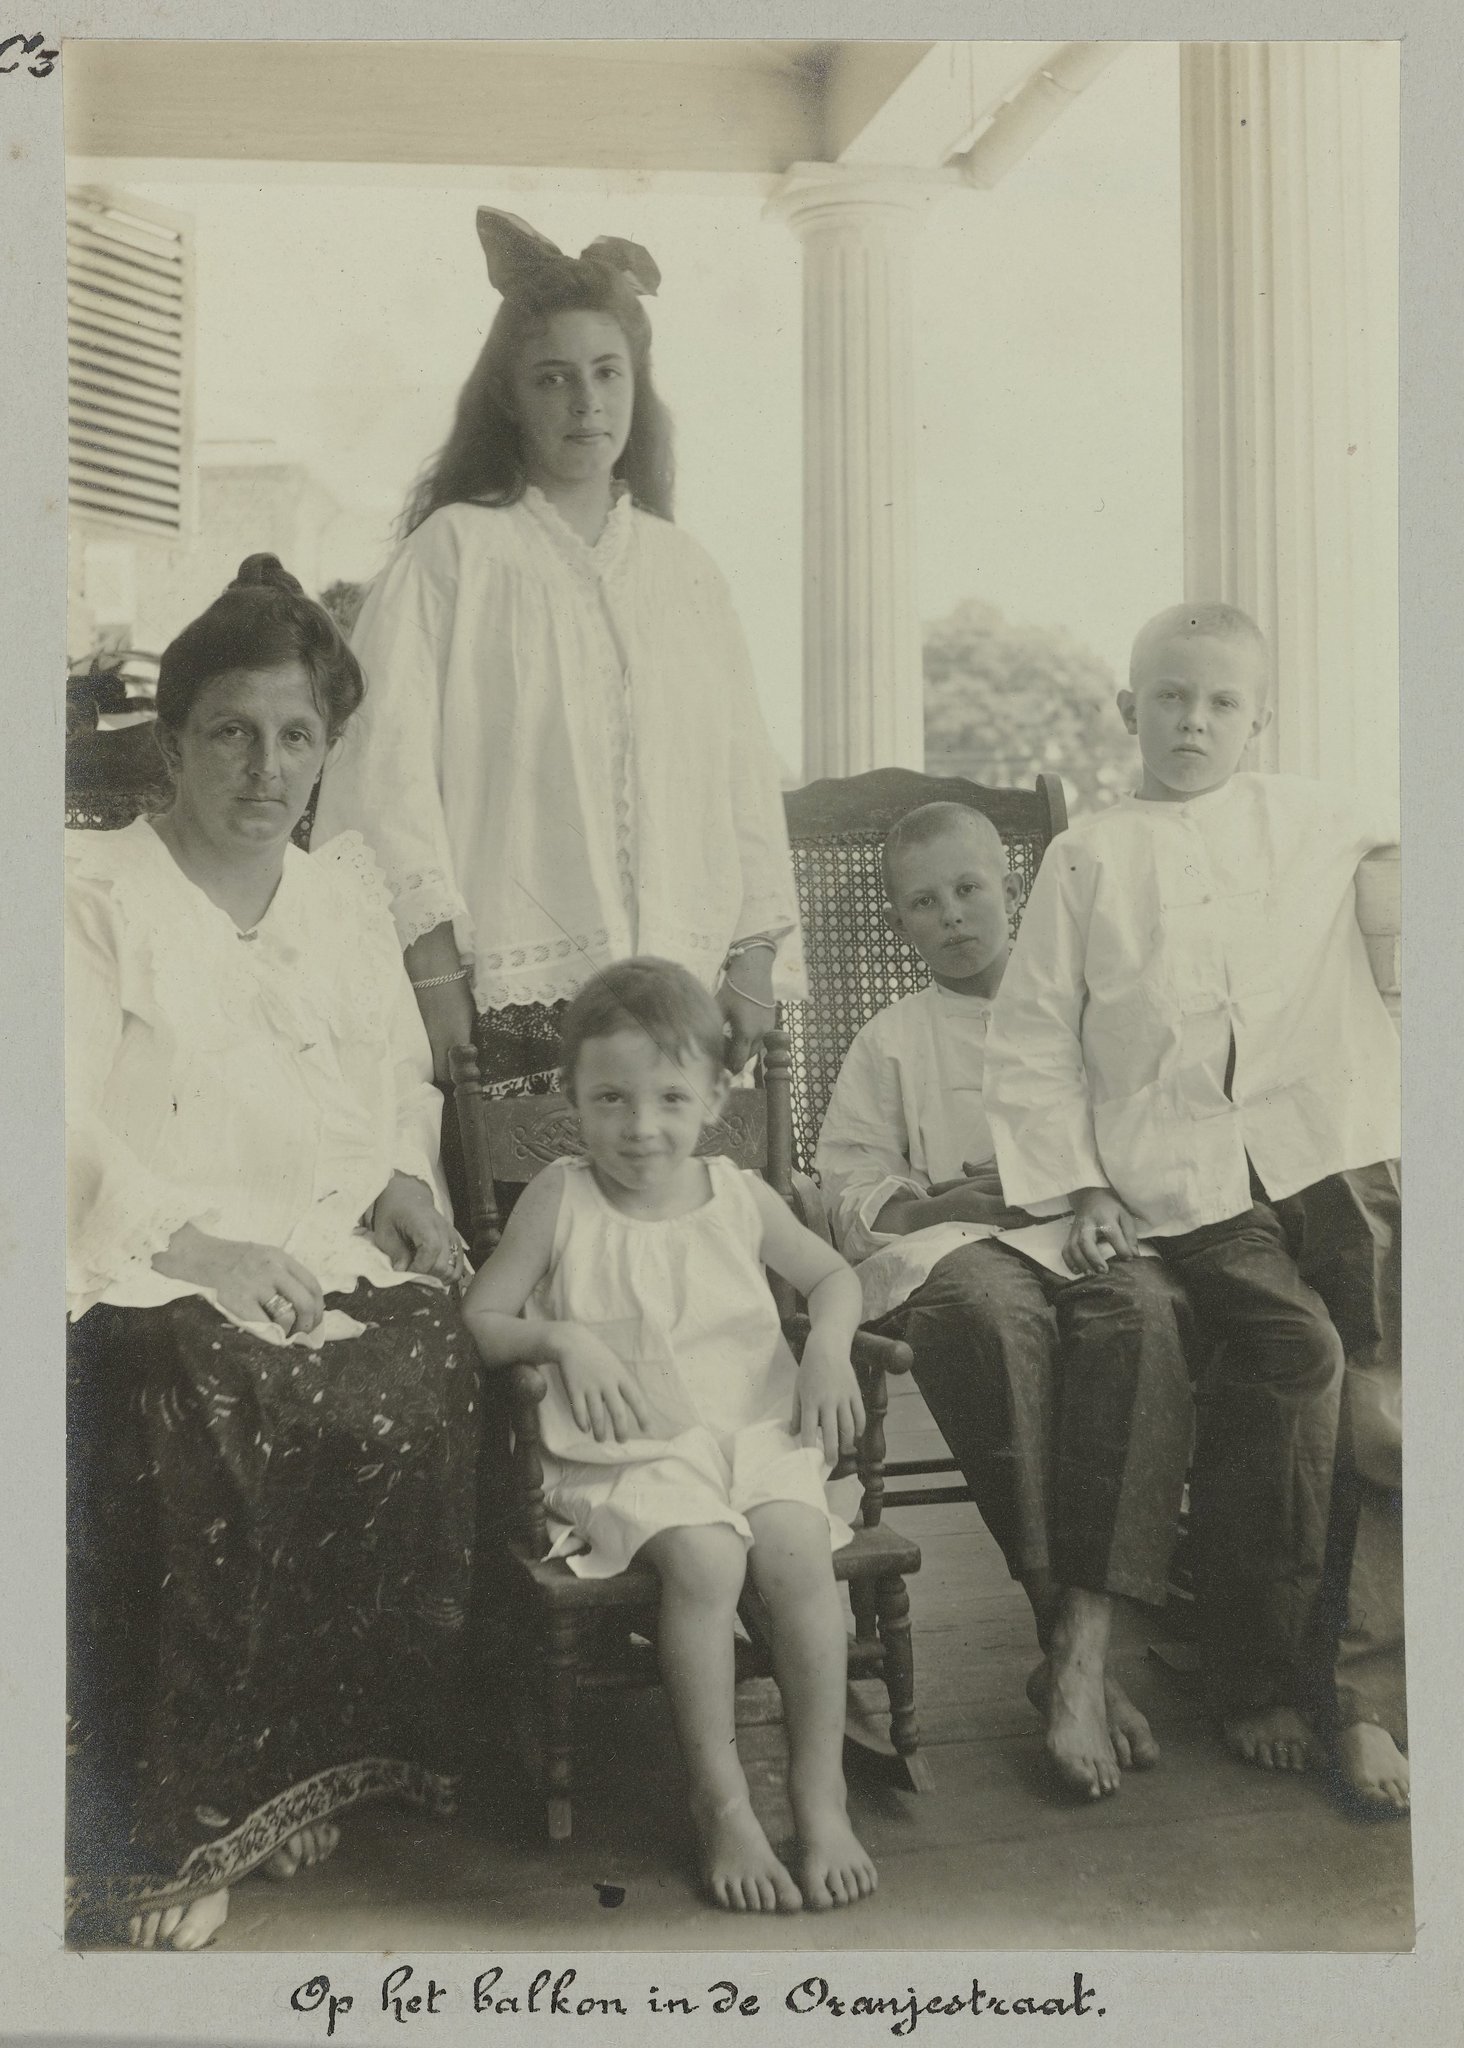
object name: photograph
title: Op het balkon in de Oranjestraat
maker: hendrik doijer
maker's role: engineer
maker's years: 1863-1925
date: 1903-1910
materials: photographic support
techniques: gelatin silver print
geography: suriname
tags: suriname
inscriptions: inscription: ‘C3 / Op het balkon in de Oranjestraat.’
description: Familiefoto van moeder met dochter en drie zoons (van de familie Doijer?) op het balkon van het huis in de Oranjestraat te Paramaribo. Onderdeel van het fotoalbum Souvenir de Voyage (deel 2), over het leven van de familie Doijer in en rond de plantage Ma Retraite in Suriname in de jaren 1903-1910.